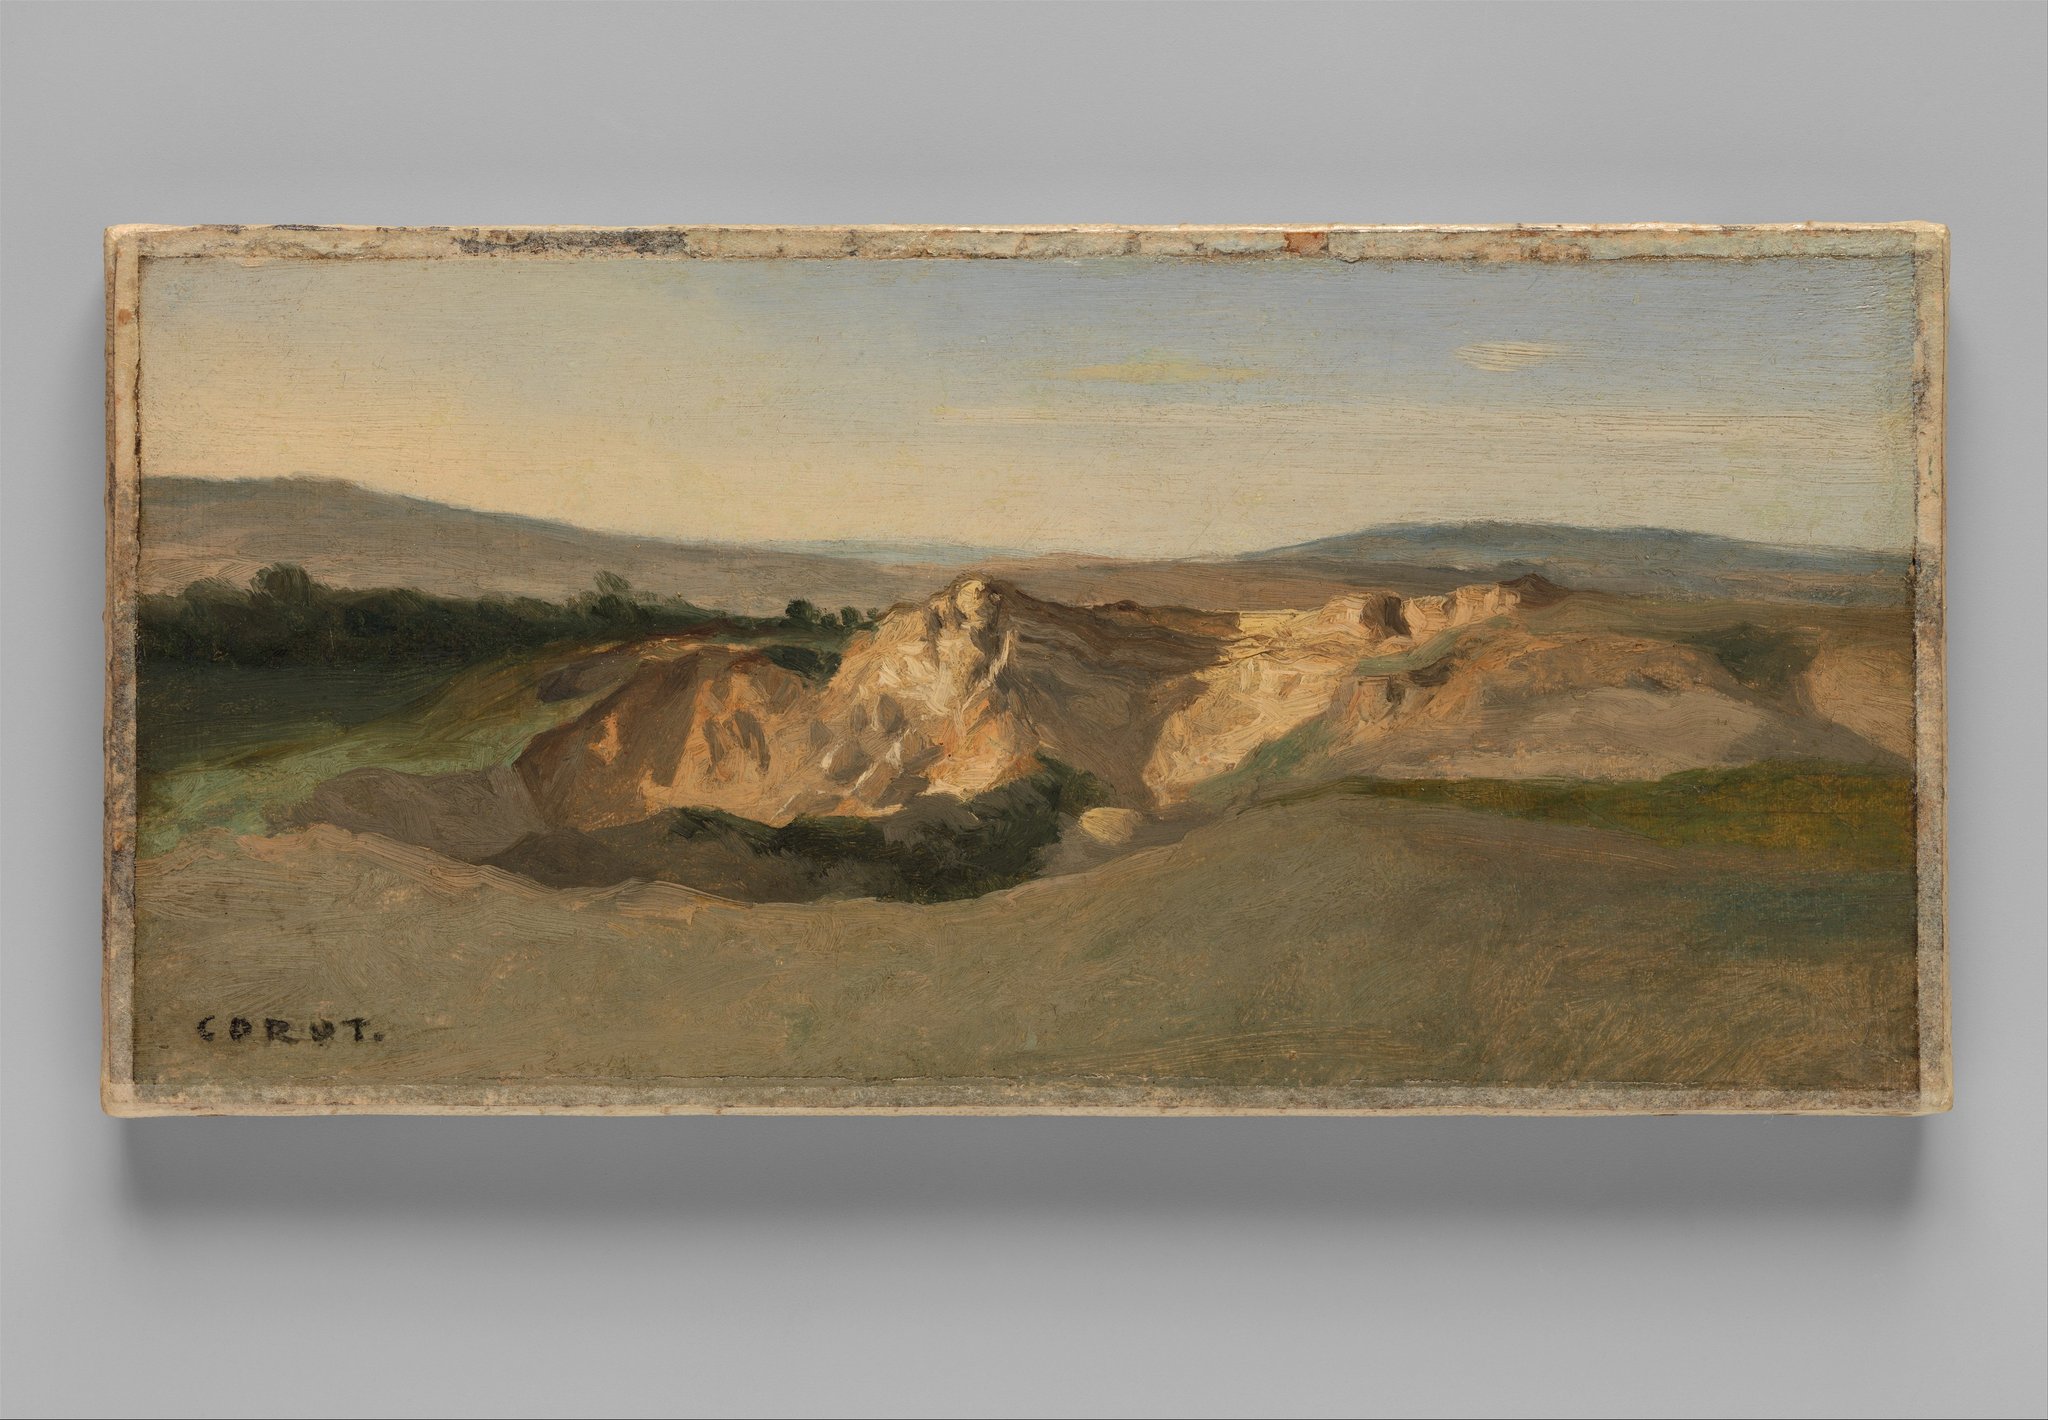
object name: drawing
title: Italian Landscape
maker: jean-baptiste-camille corot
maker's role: artist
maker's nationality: french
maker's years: 1796-1875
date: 1825-1828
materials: canvas, oil, paper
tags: landscapes